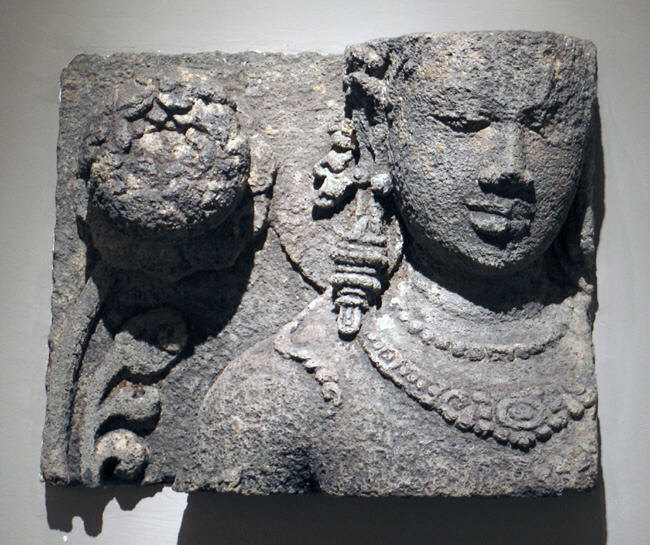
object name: relief fragment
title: Male Deity, probably Padmapani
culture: indonesian, javanese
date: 867-900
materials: stone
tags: buddhism,deities